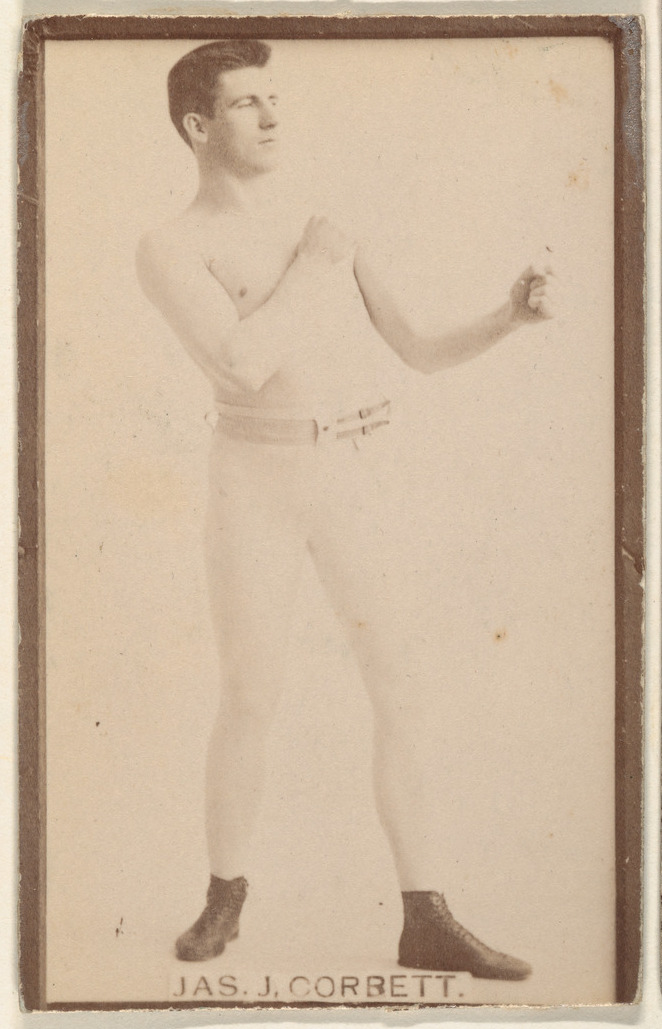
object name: photograph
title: James J. Corbett, from the Actresses series (N668)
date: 1888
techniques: albumen silver print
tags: men,portraits,boxing